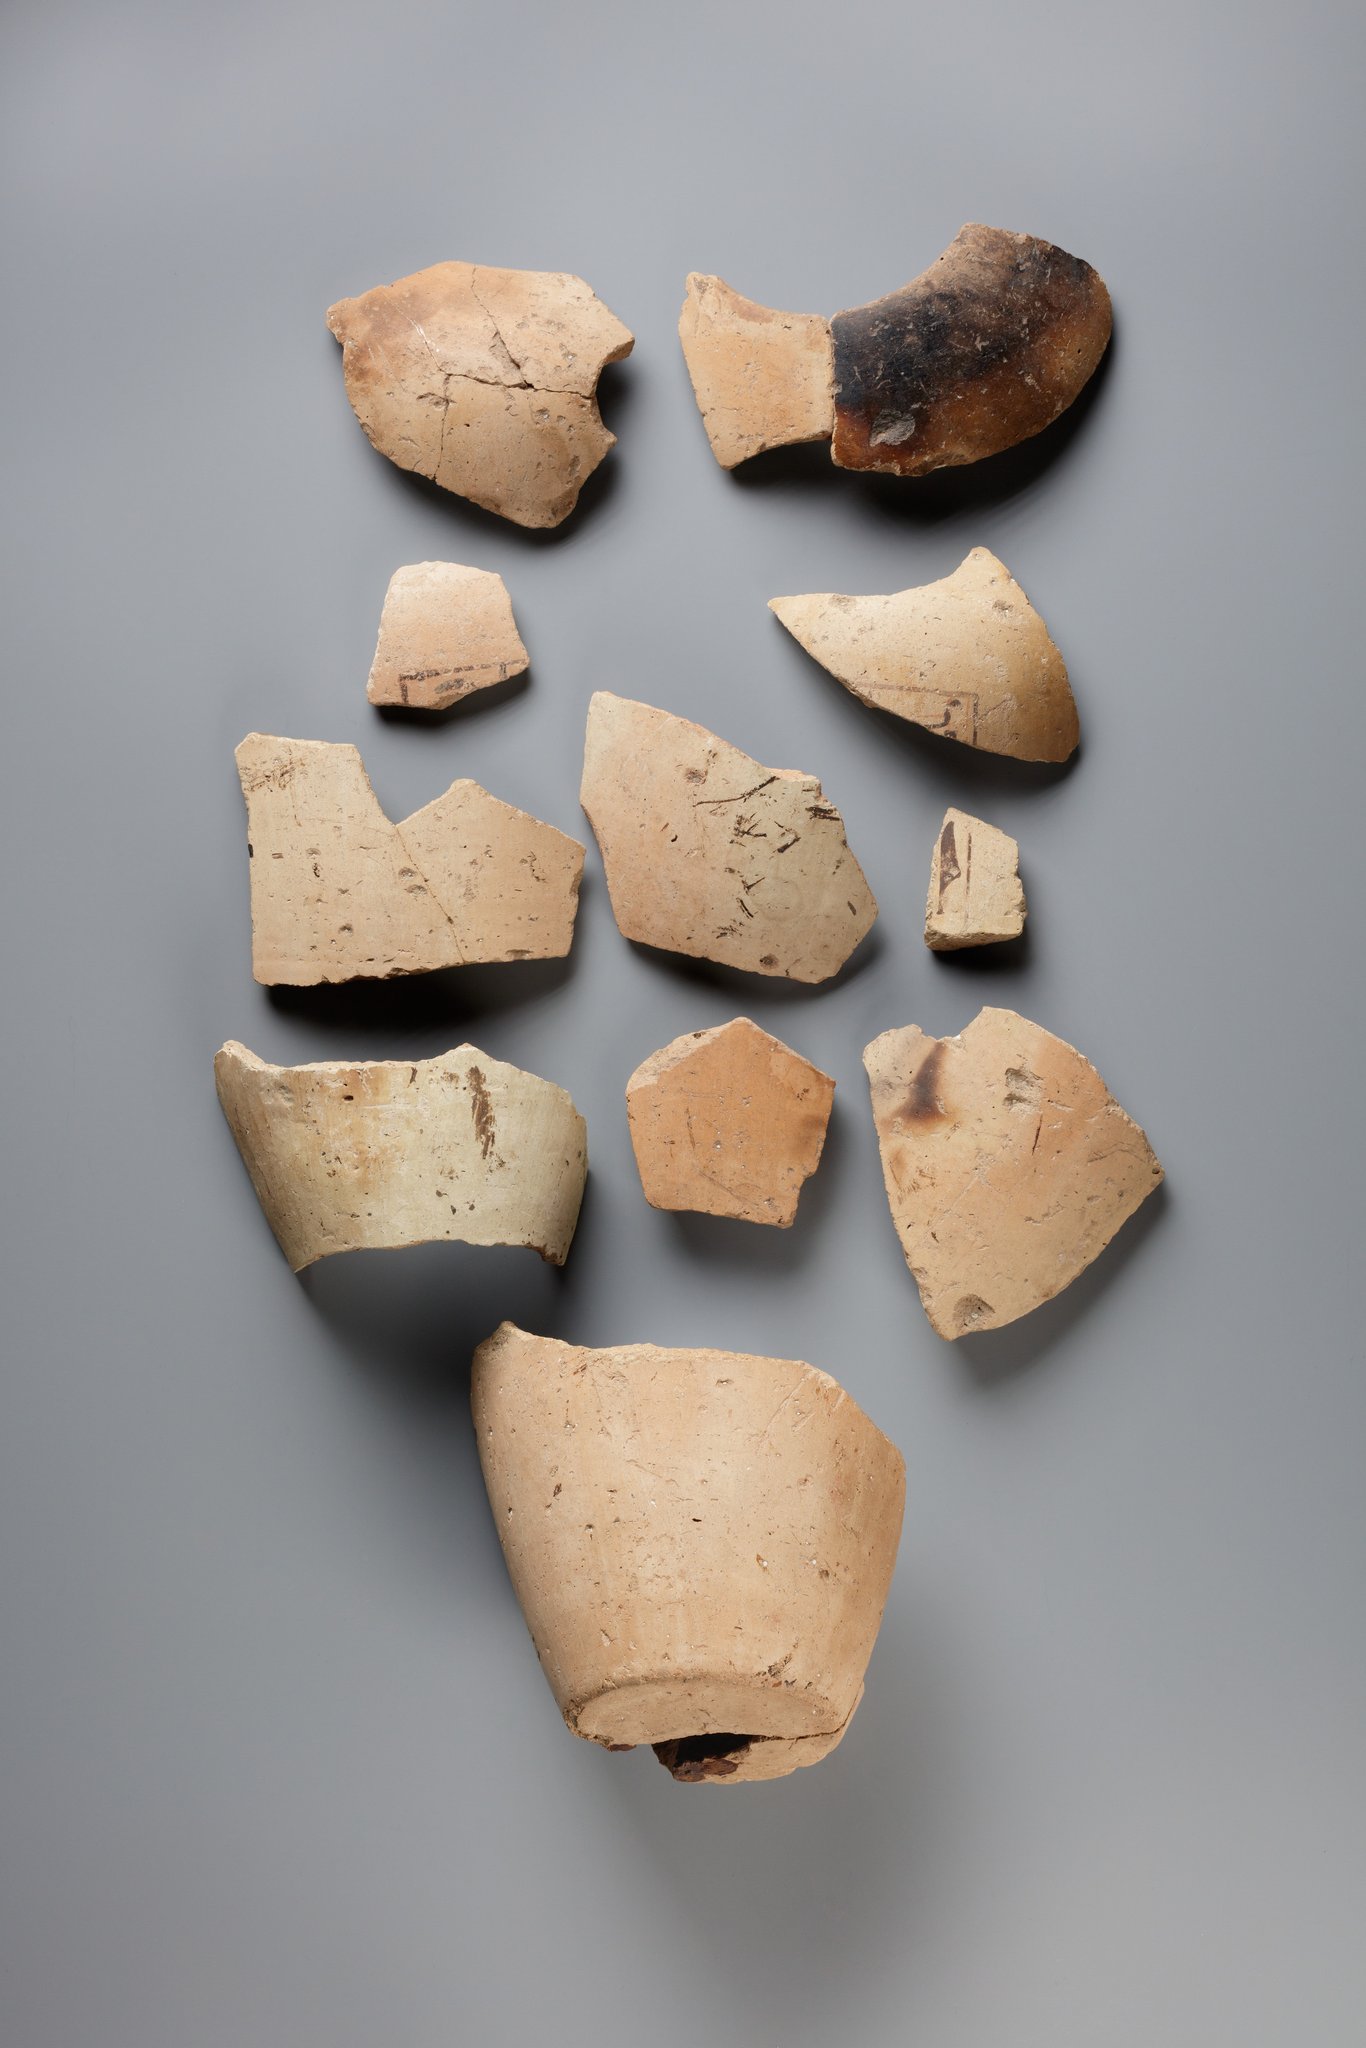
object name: canopic jar, senimen, fragment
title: Fragments of Canopic Jar(s) Belonging to Senimen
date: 1479-1458 BCE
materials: paint, pottery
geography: egypt